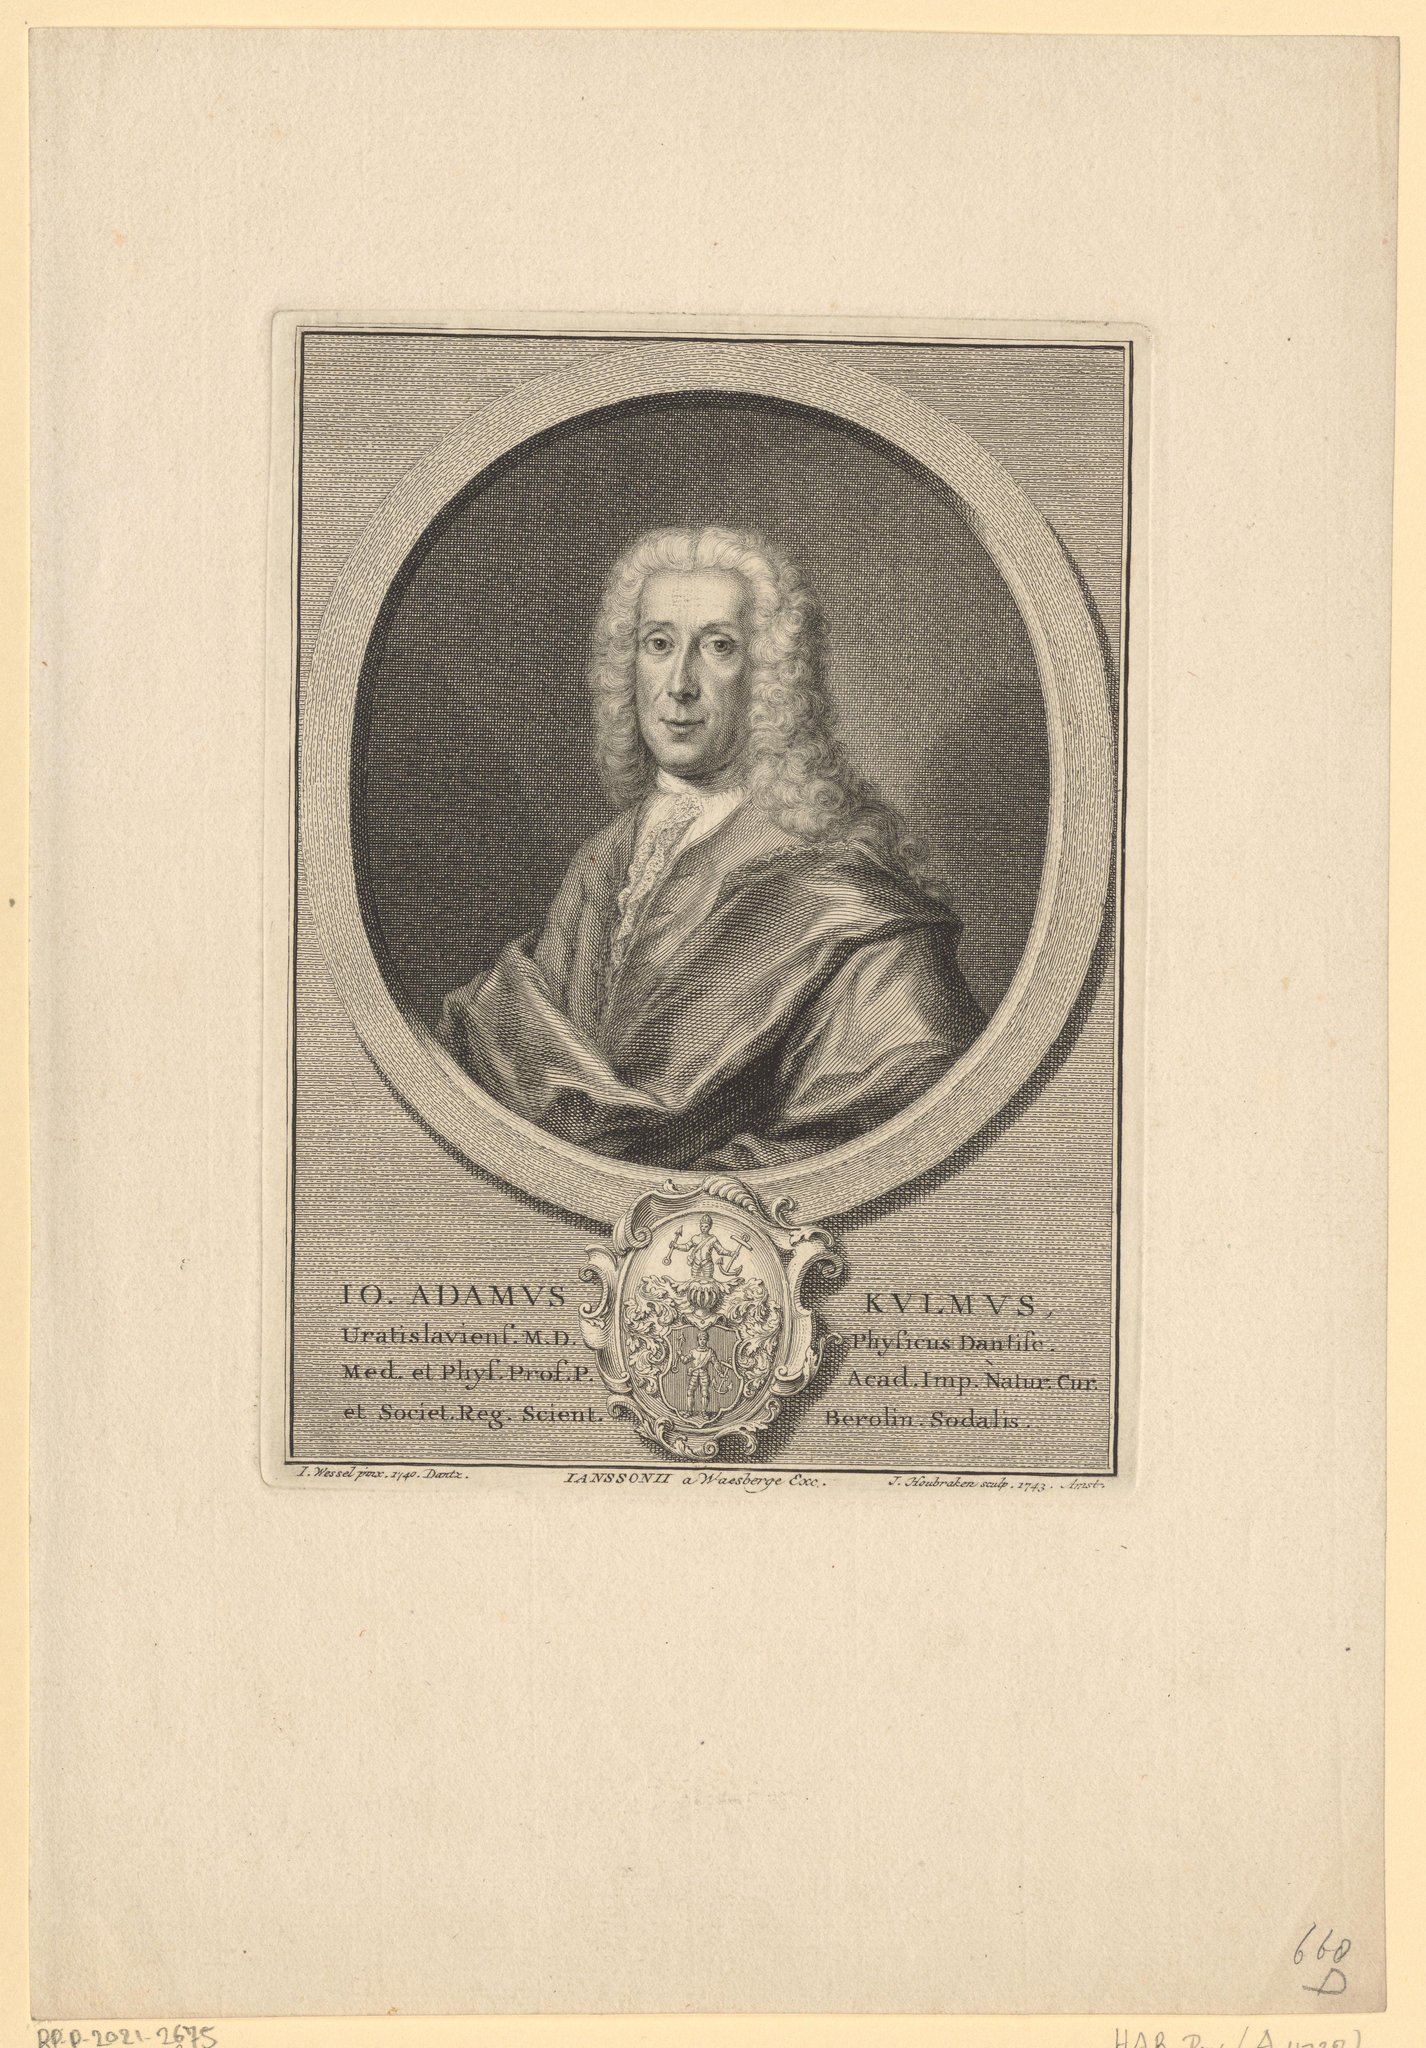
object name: print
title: Portret van Johan Adam Kulmus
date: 1743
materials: paper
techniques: engraving, etching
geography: amsterdam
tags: historical persons, armorial bearing, heraldry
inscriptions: date